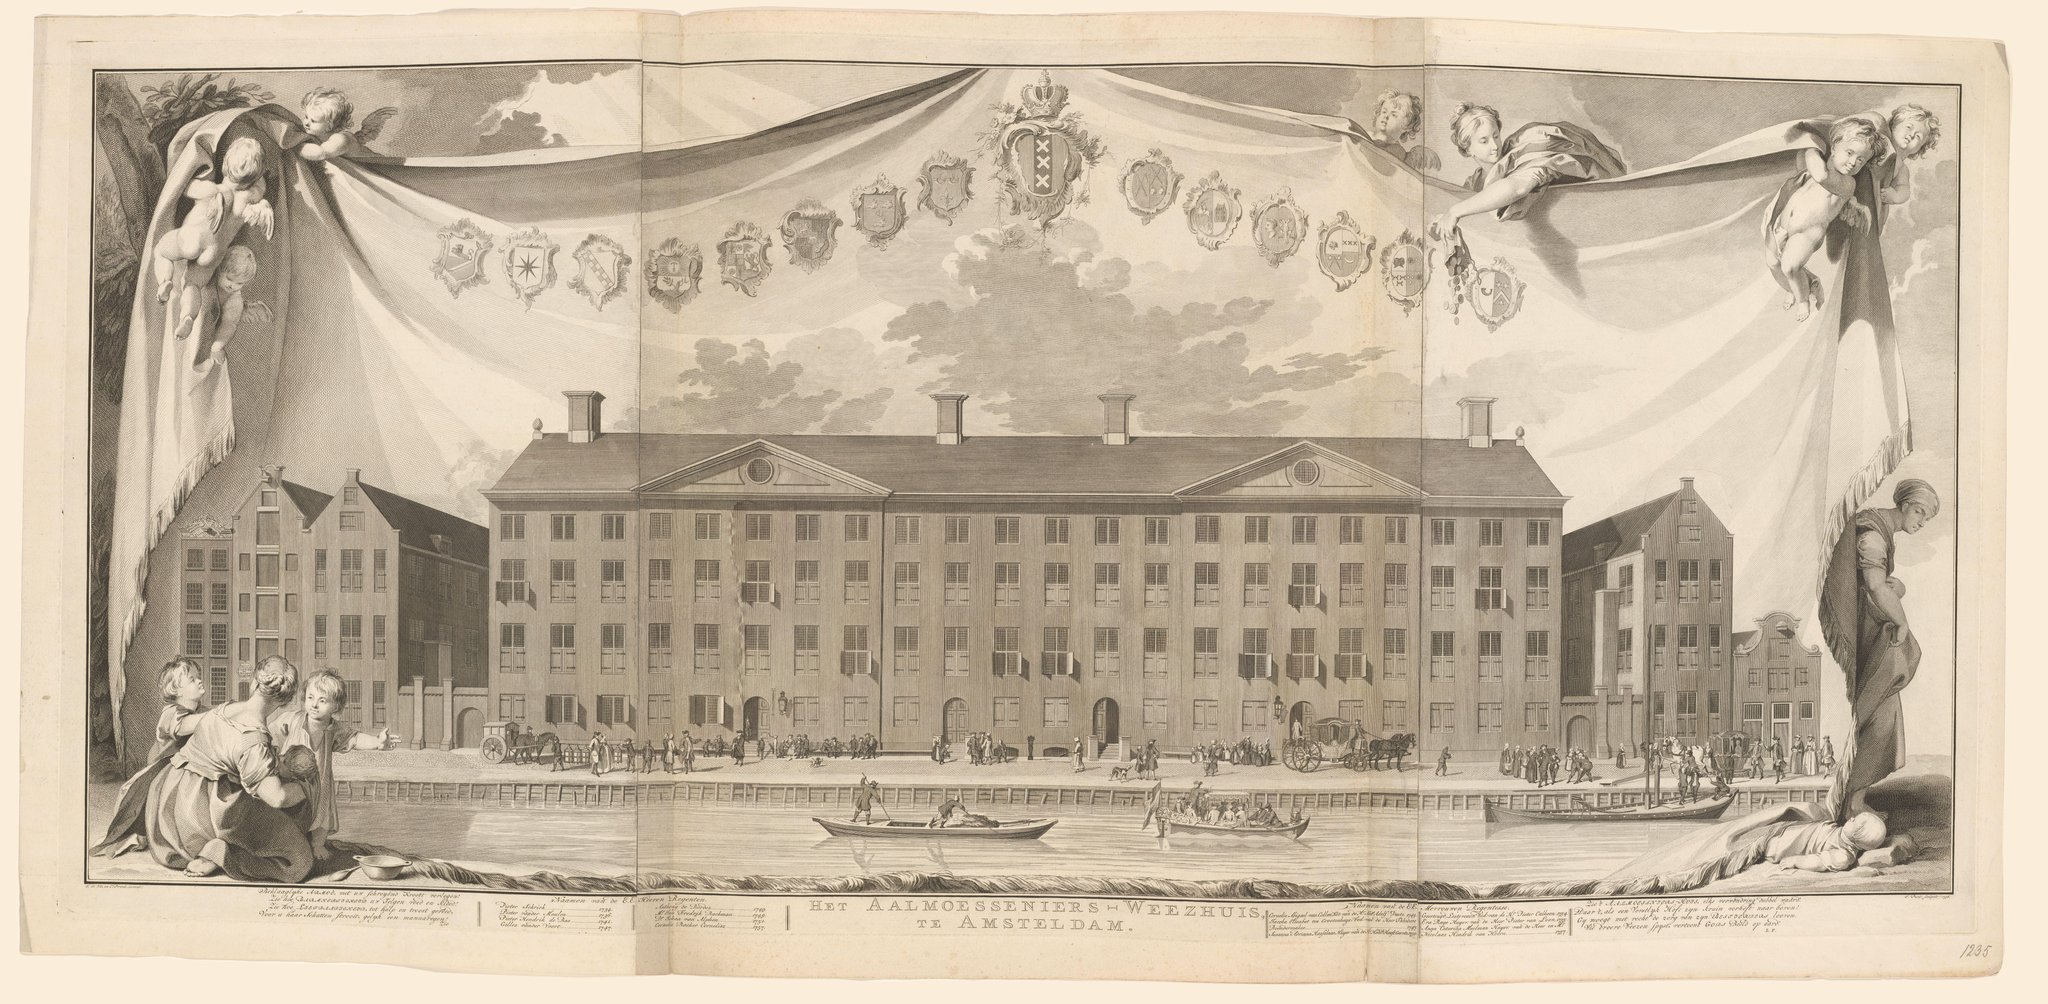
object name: print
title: Het Aalmoesseniers-Weezhuis te Amsteldam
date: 1758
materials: paper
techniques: engraving, etching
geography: amsterdam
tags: coat of arms (as symbol of the state, etc.) (+ city; municipal), public welfare, orphanage, cupids: 'amores', 'amoretti', 'putti', canals, waters (in city) (+ city(-scape) with figures, staffage), armorial bearing, heraldry, street (+ city(-scape) with figures, staffage)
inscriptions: date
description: Gezicht op het Aalmoezeniersweeshuis te Amsterdam, bestaande uit drie aan elkaar geplakte delen.